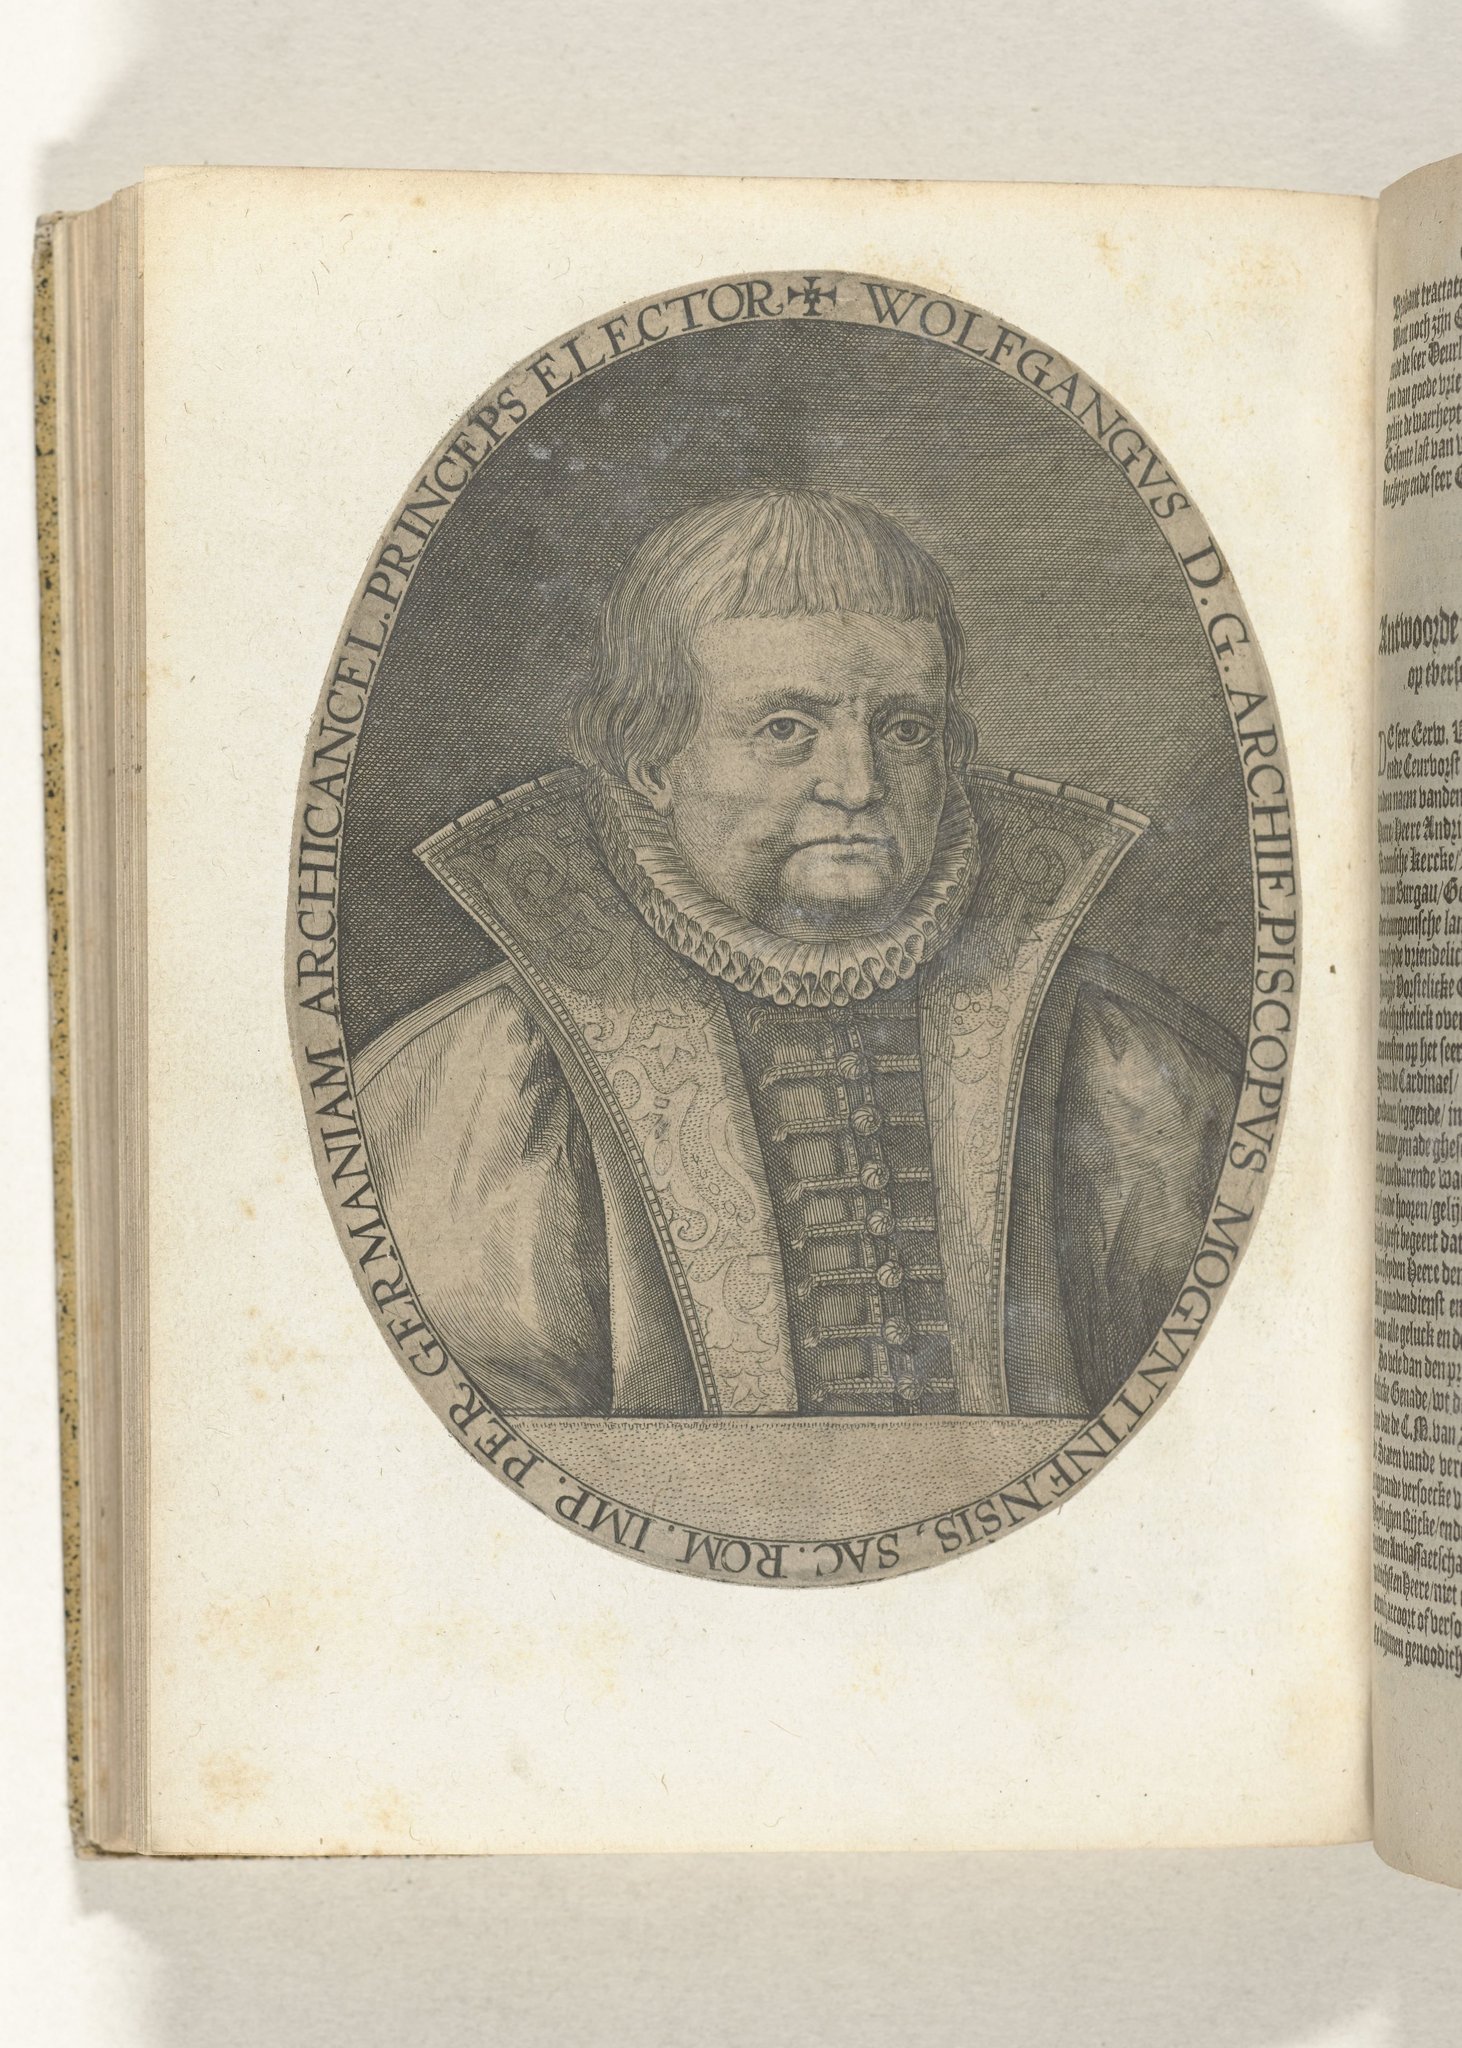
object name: pamphlet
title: Portret van Wolfgang von Dalberg, aartsbisschop en keurvorst van Mainz, 1599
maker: Anonymous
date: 1590-1599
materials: paper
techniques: engraving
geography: low countries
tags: aartsbisschop, aartsbisschop en keurvorst van mainz wolfgang von dalberg, tachtigjarige oorlog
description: Portret van Wolfgang von Dalberg, aartsbisschop en keurvorst van Mainz, 1599. Ovaal portret met borstbeeld van de aartsbisschop, met randschrift in het Latijn. Uitgeknipt en ingeplakt in het pamflet getiteld: Den Spaenschen ende Arragoenschen spiegel. Inde welcke men mach claerlick ende waerachtich sien tot wat eynde ... het voornemen is ... van 't Spaensche Crijchsvolck, dat hem desen Winter heeft gehouden in den Westphaelschen Creyts.